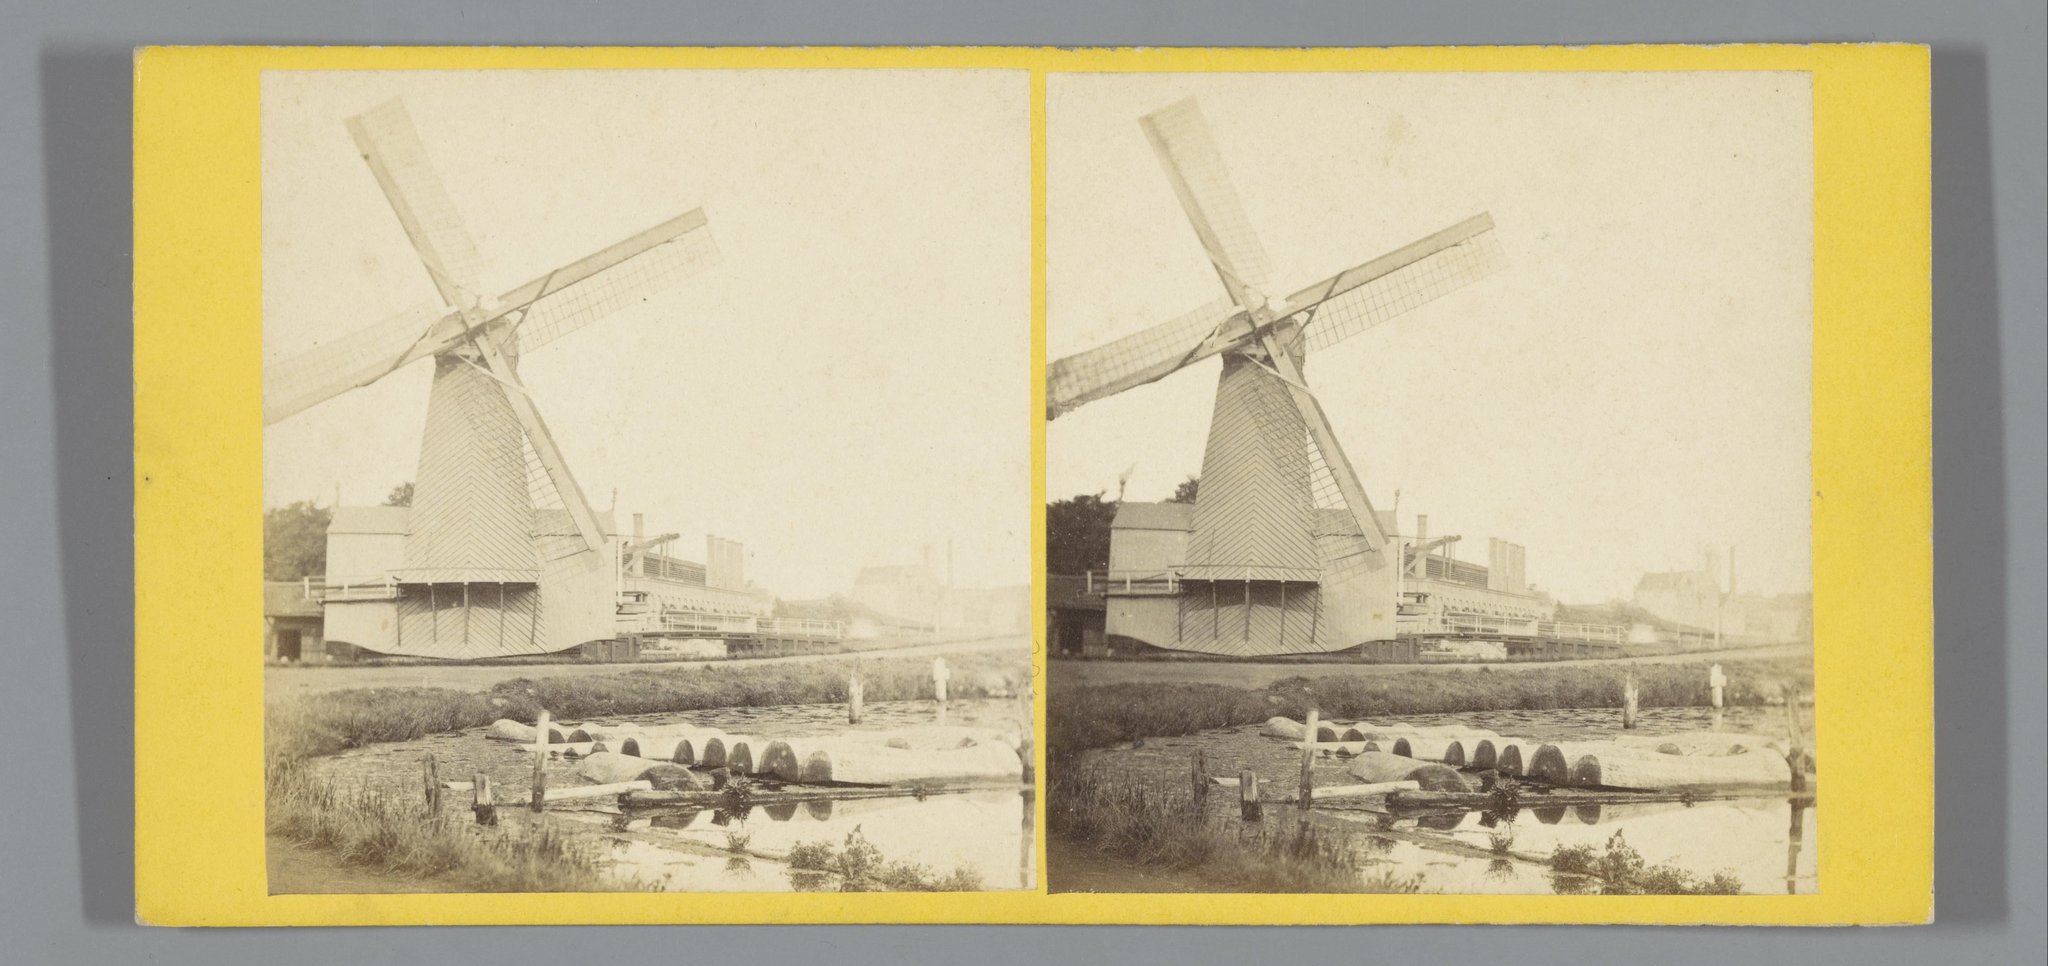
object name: stereograph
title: Gezicht op de houtzaagmolen bij de Raam-Barrière in Amsterdam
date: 1860-1885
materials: cardboard, photographic support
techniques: albumen print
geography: amsterdam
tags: saw-mill (works), amsterdam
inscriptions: inscription: ‘HOUTZAAGMOLEN/ BIJ DE/ Raam-Barrière te Amsterdam. No./ A. JAGER, WATER 110, TE AMSTERDAM.’, annotation: ‘RBK’